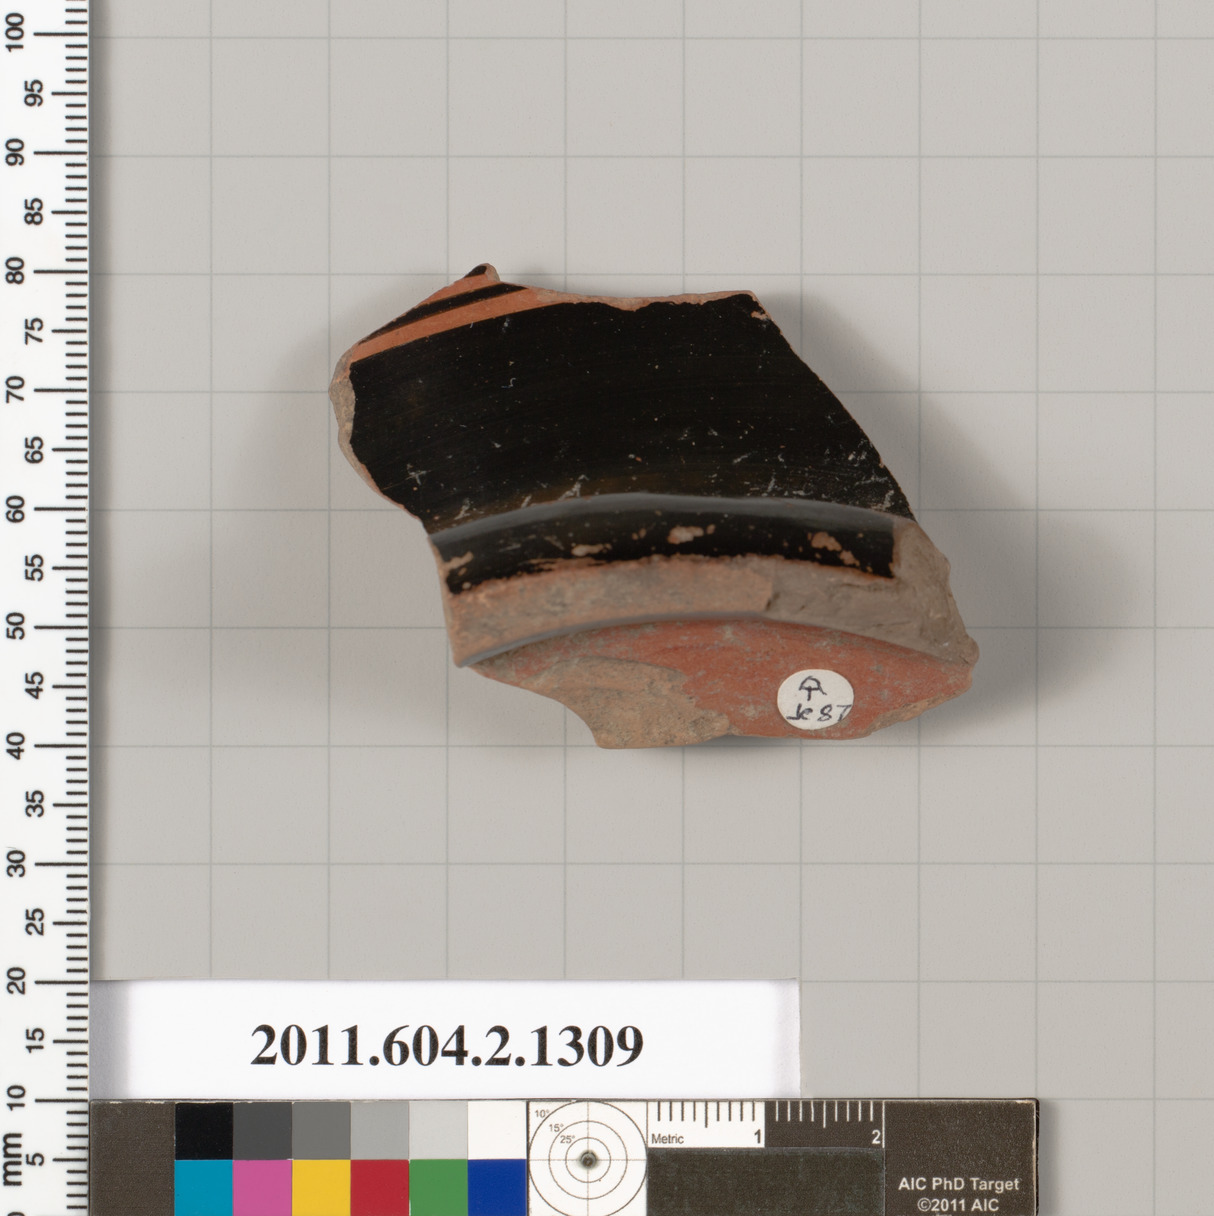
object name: skyphos fragment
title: Terracotta fragment of a skyphos (deep drinking cup)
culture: greek, attic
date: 500-451 BCE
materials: terracotta